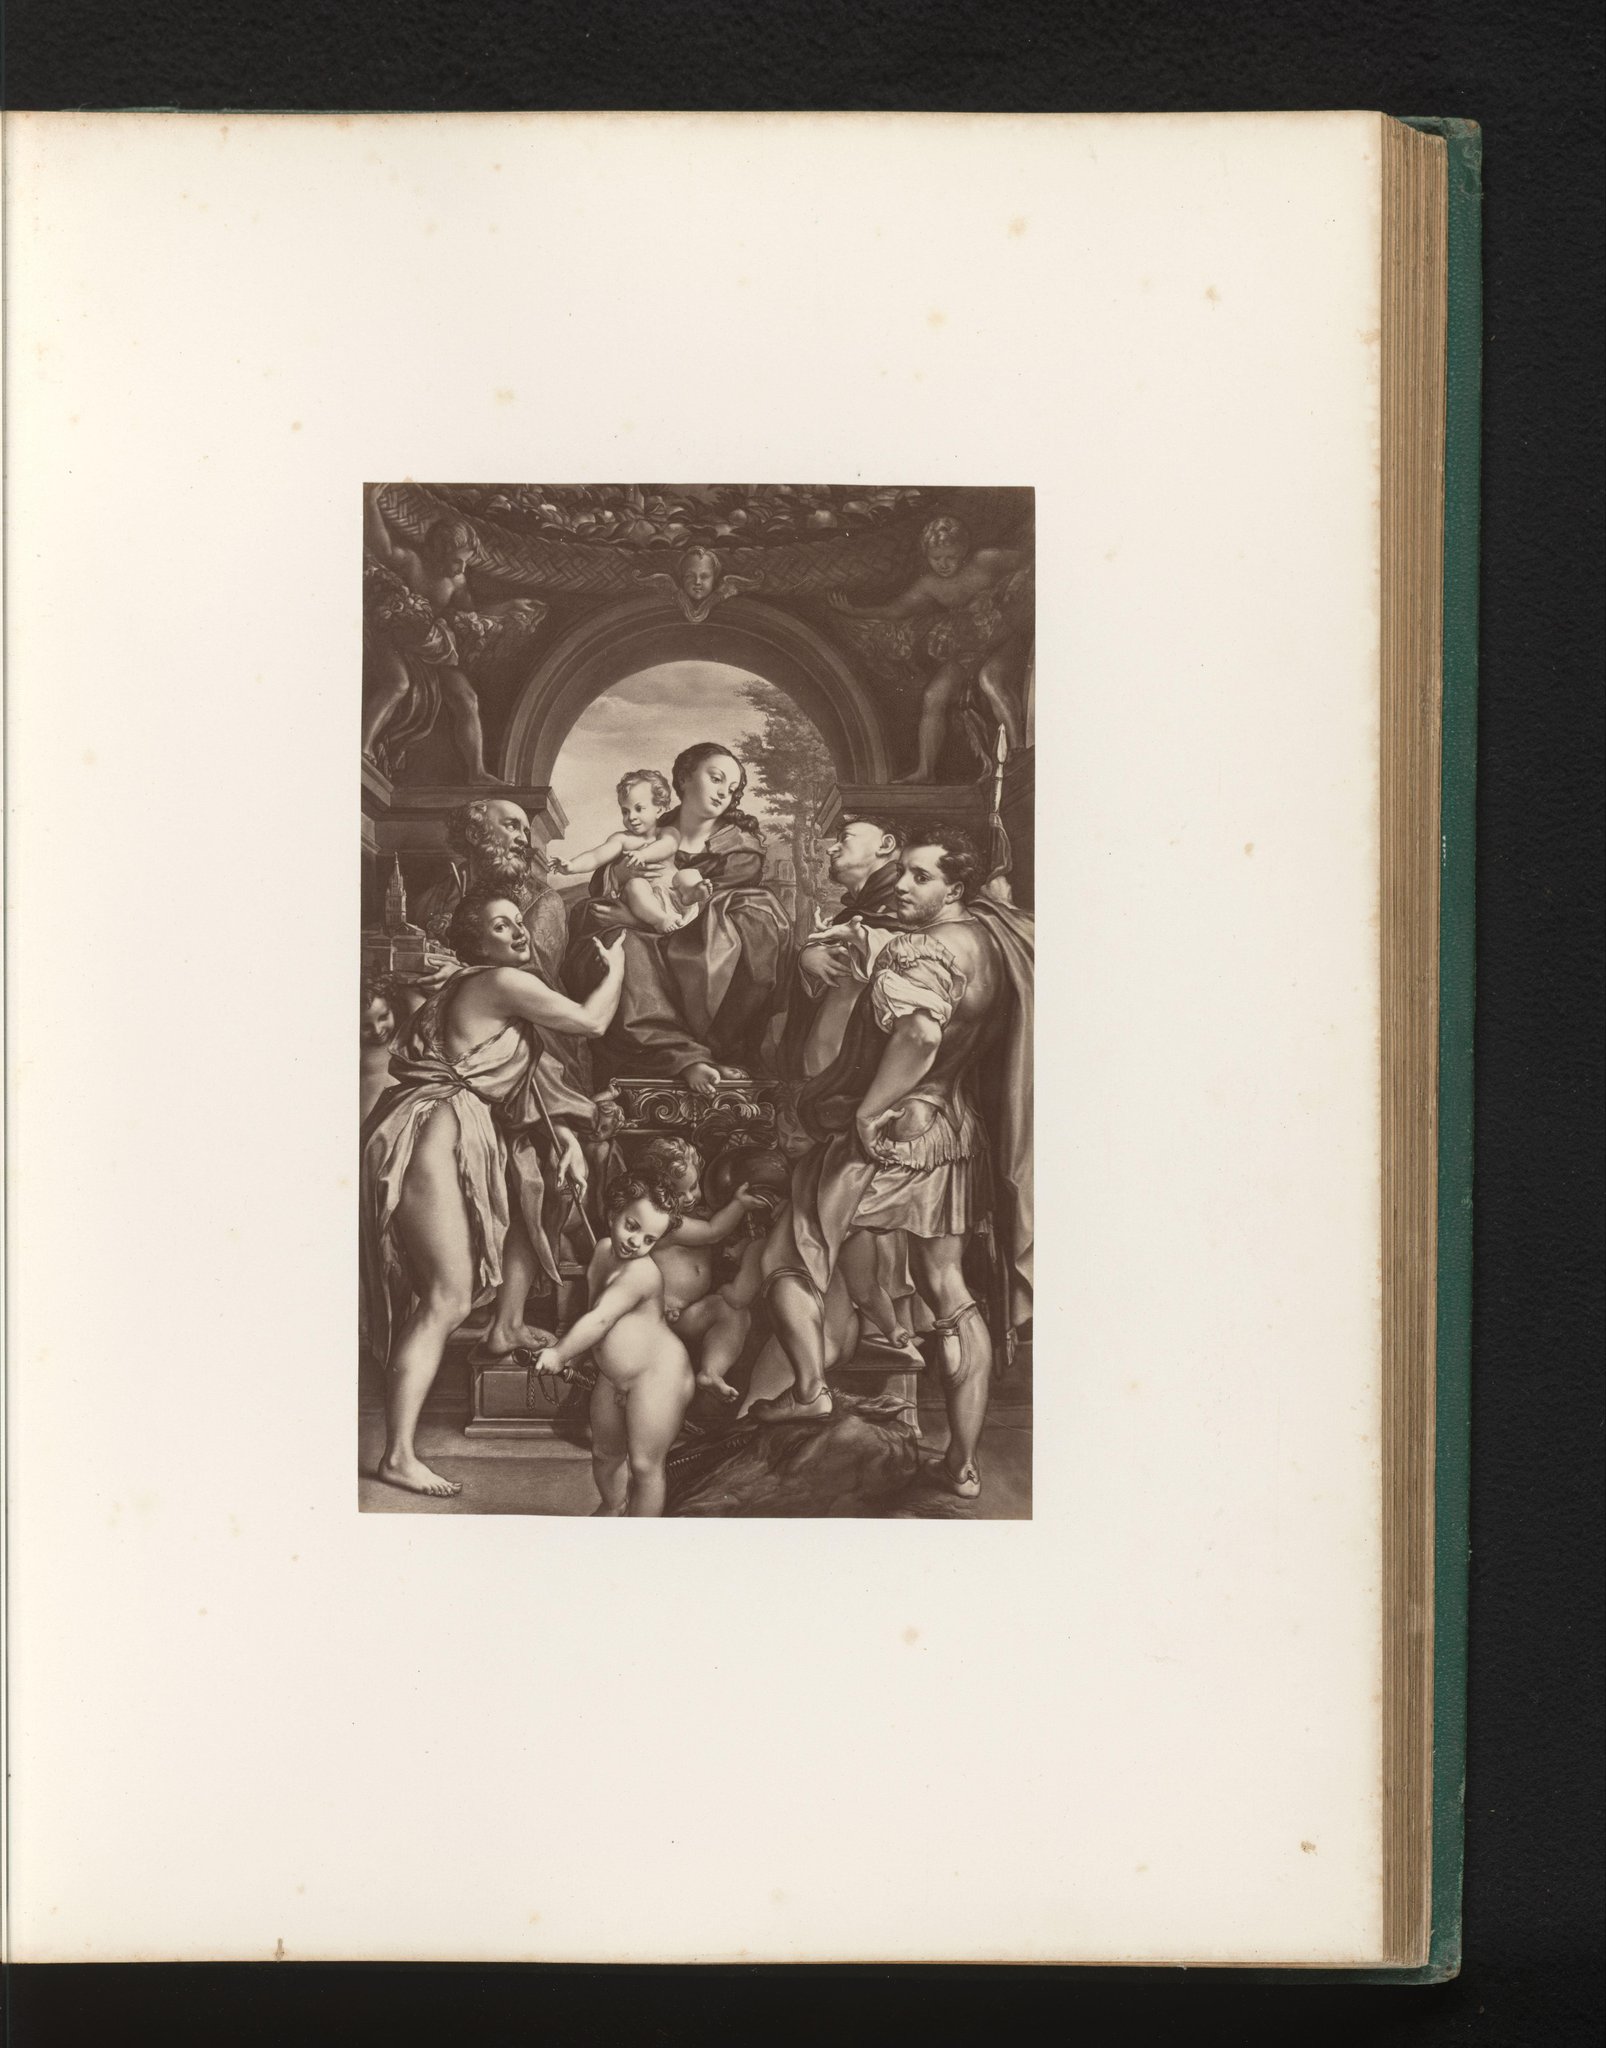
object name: photograph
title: Fotoreproductie van het schilderij Madonna met kind en Sint-Joris door Correggio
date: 1870-1875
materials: paper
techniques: albumen print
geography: berlin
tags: mary sitting or enthroned, the christ-child in front of her, sitting in her lap (or in front of her bosom) (+ donor(s), supplicant(s), whether or not with patron saint(s)), the warrior martyr george (georgius); possible attributes: banner (red cross on white field), (red) cross, dragon, (white) horse, broken lance, shield (with cross), sword